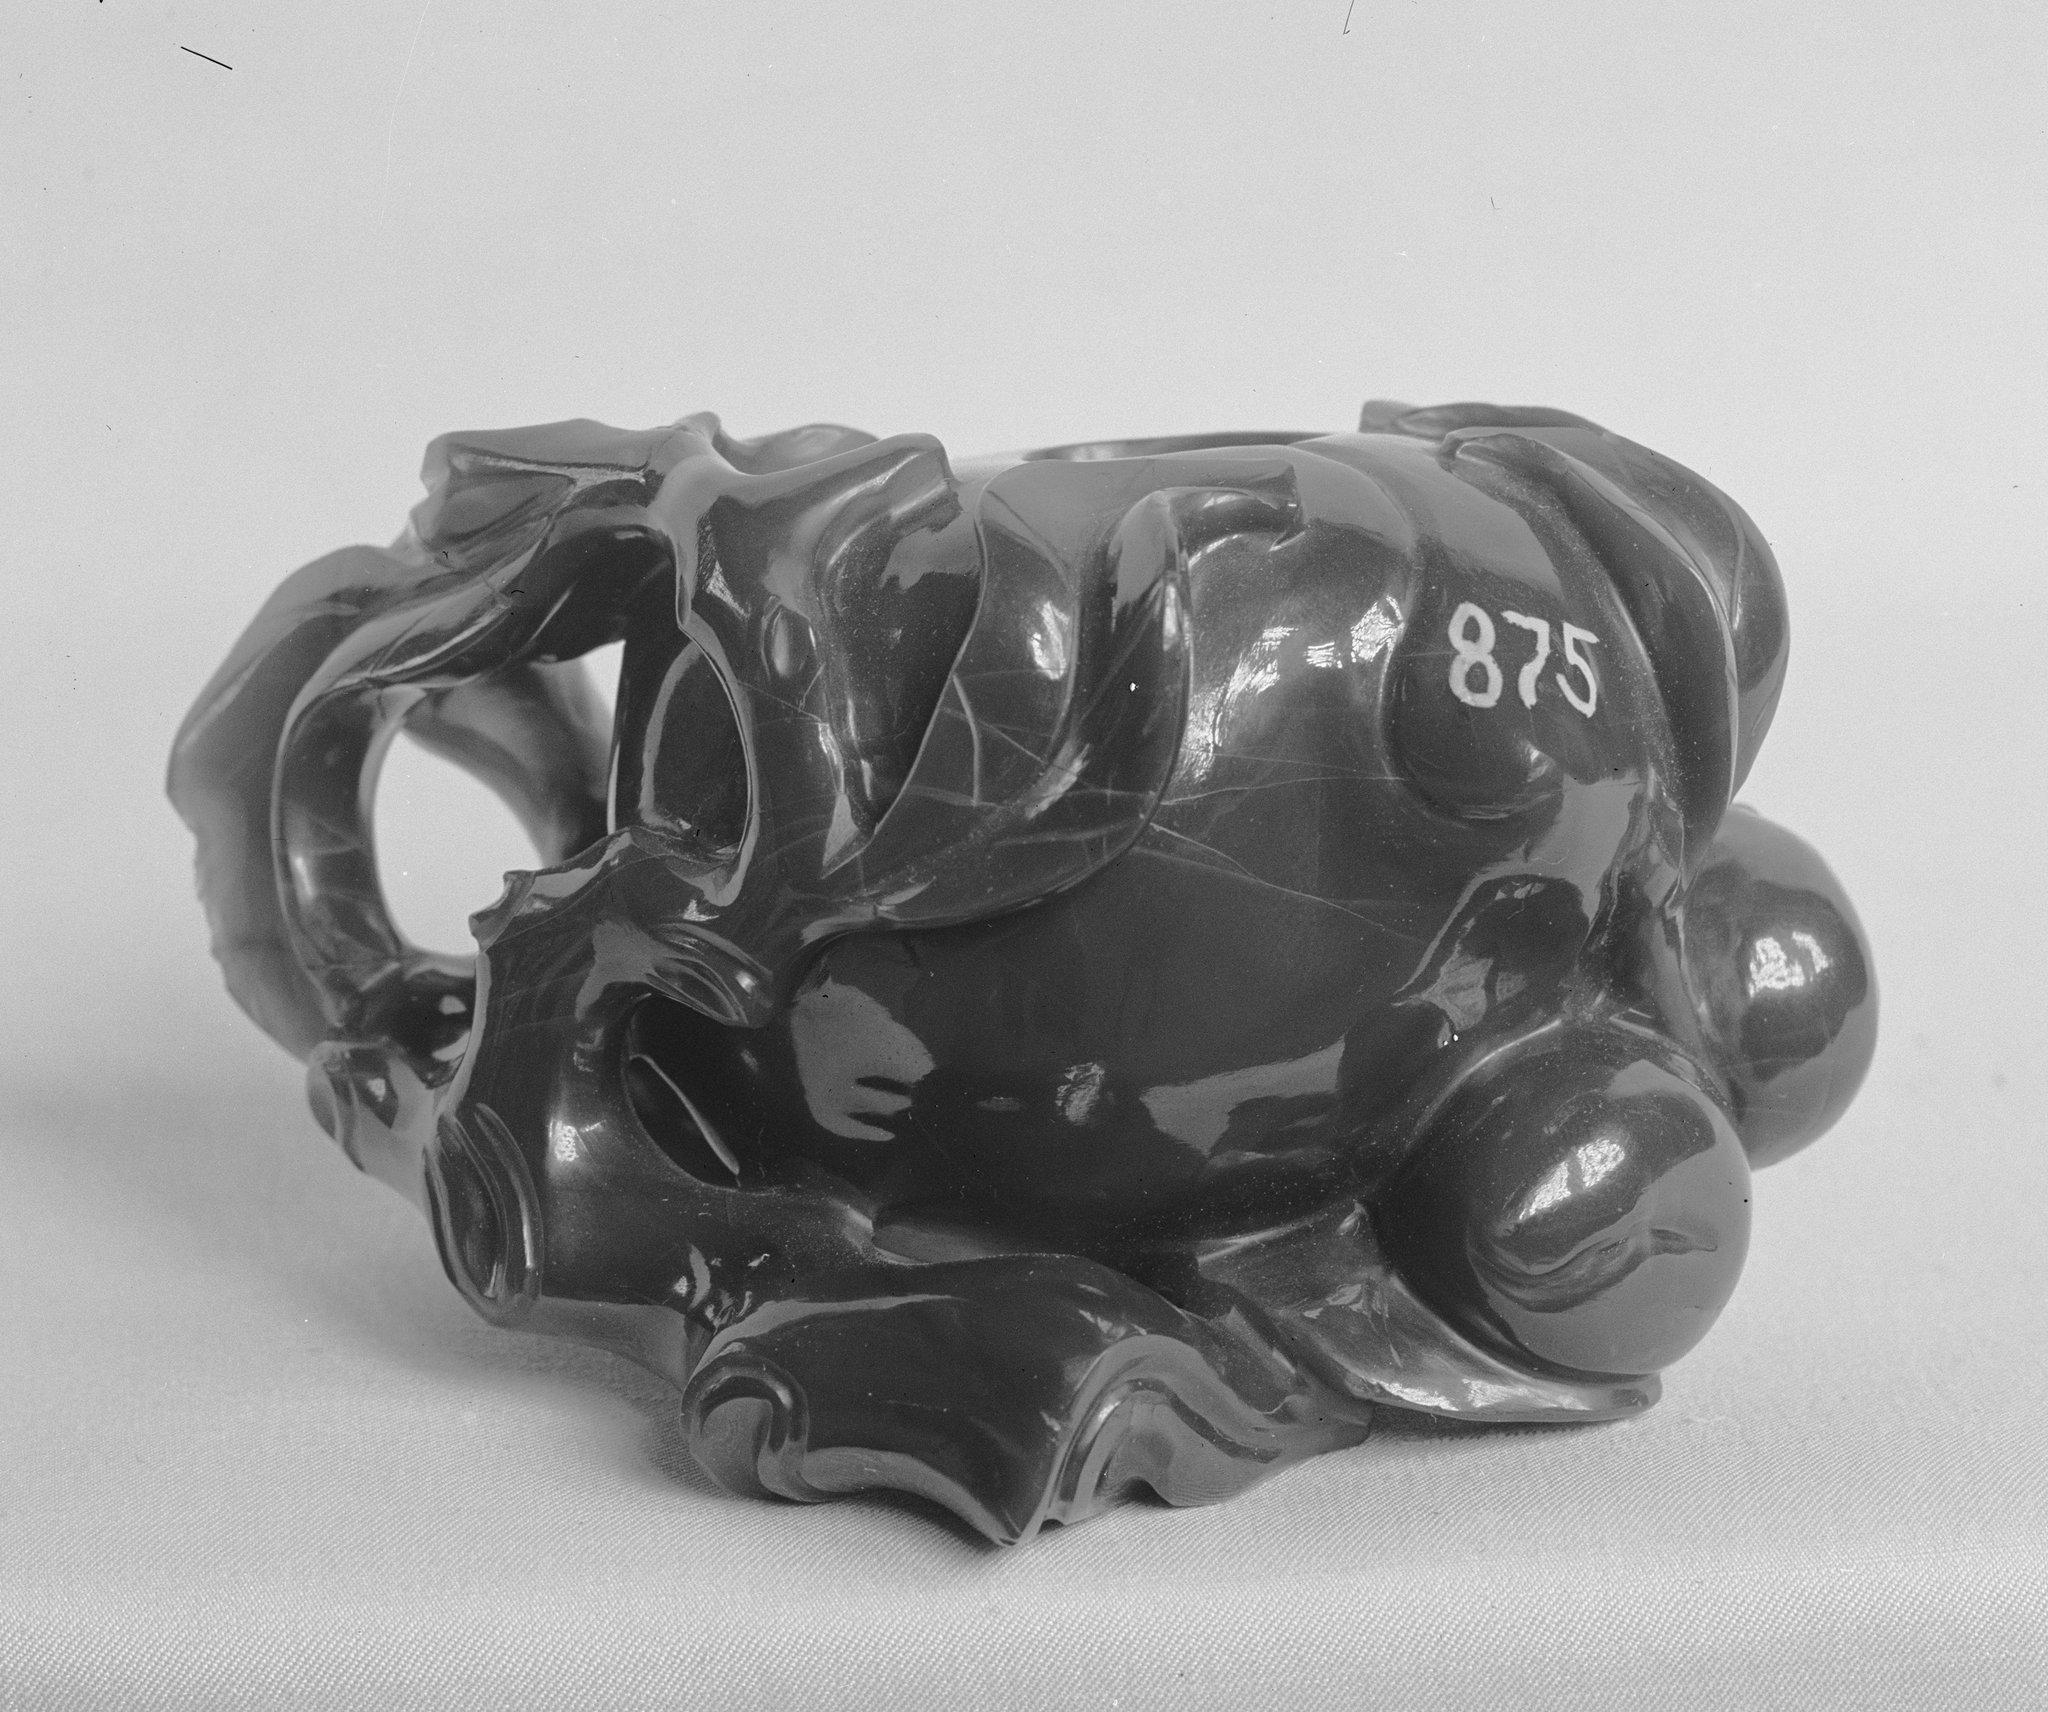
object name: water pot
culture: chinese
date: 1701-1800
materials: stone, gemstone